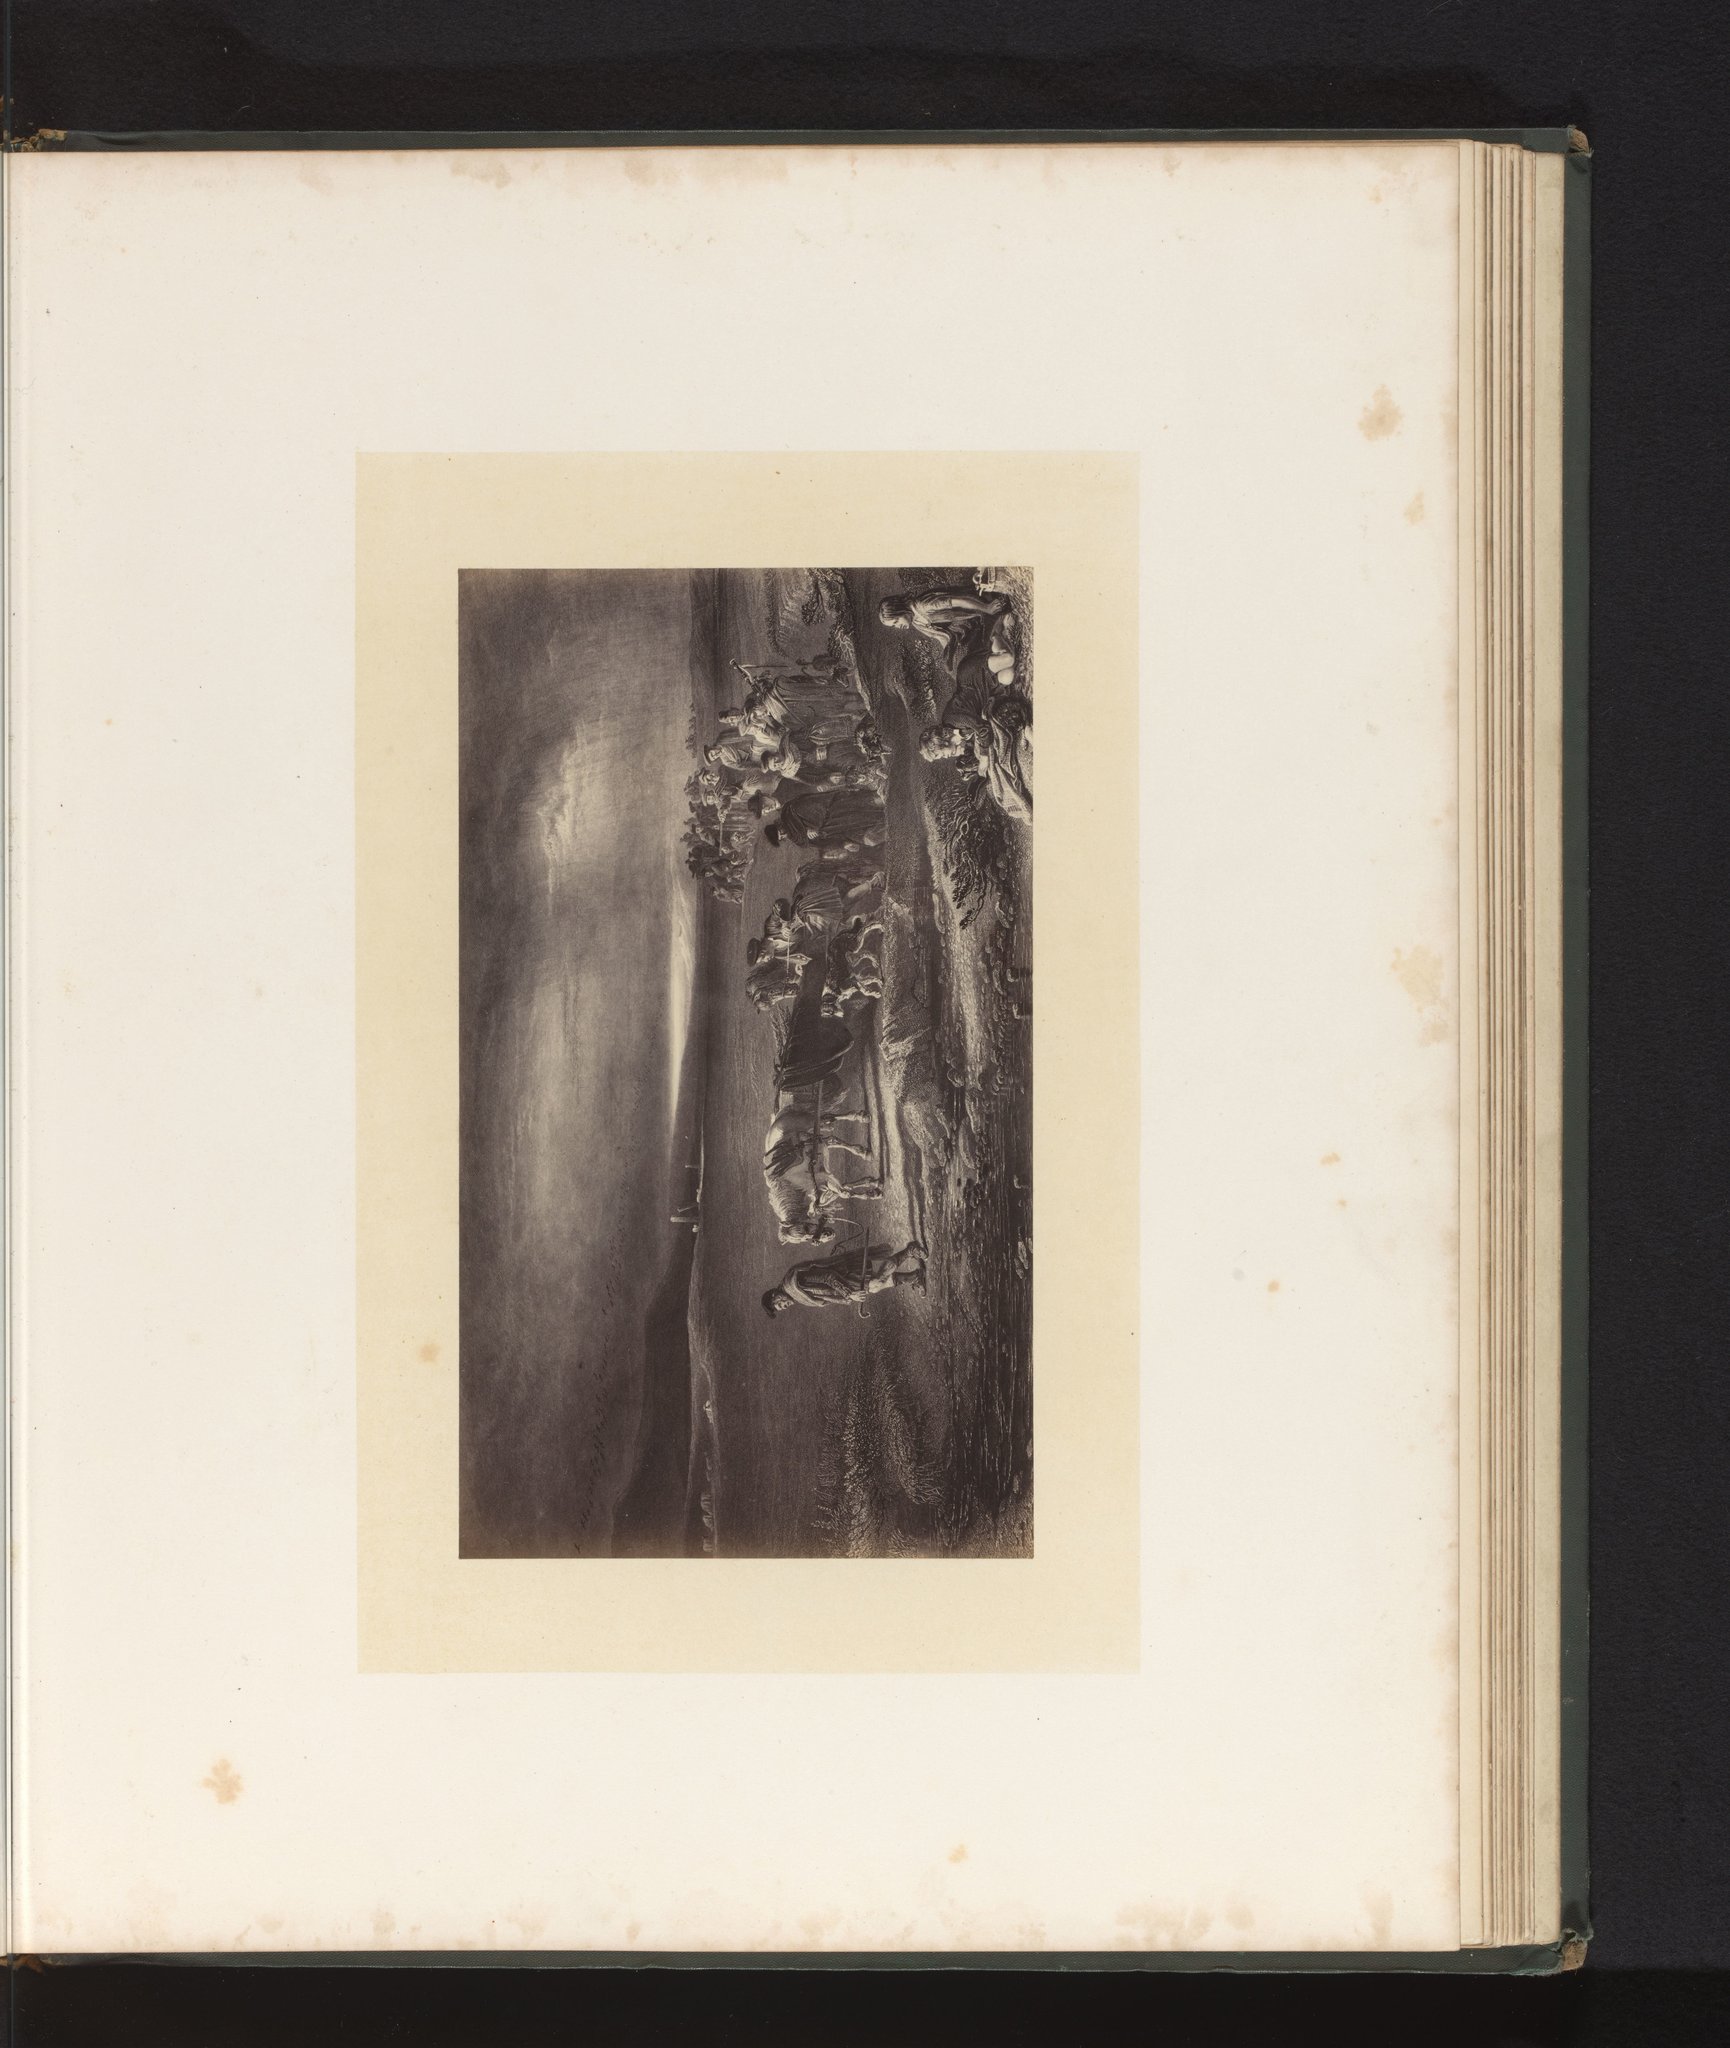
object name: page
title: Fotoreproductie van een gravure van A Highland Funeral, naar het schilderij door Sir George Harvey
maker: thomas annan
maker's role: fotograaf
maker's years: 1829-1887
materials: photographic support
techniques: albumen print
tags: cortege, funeral procession